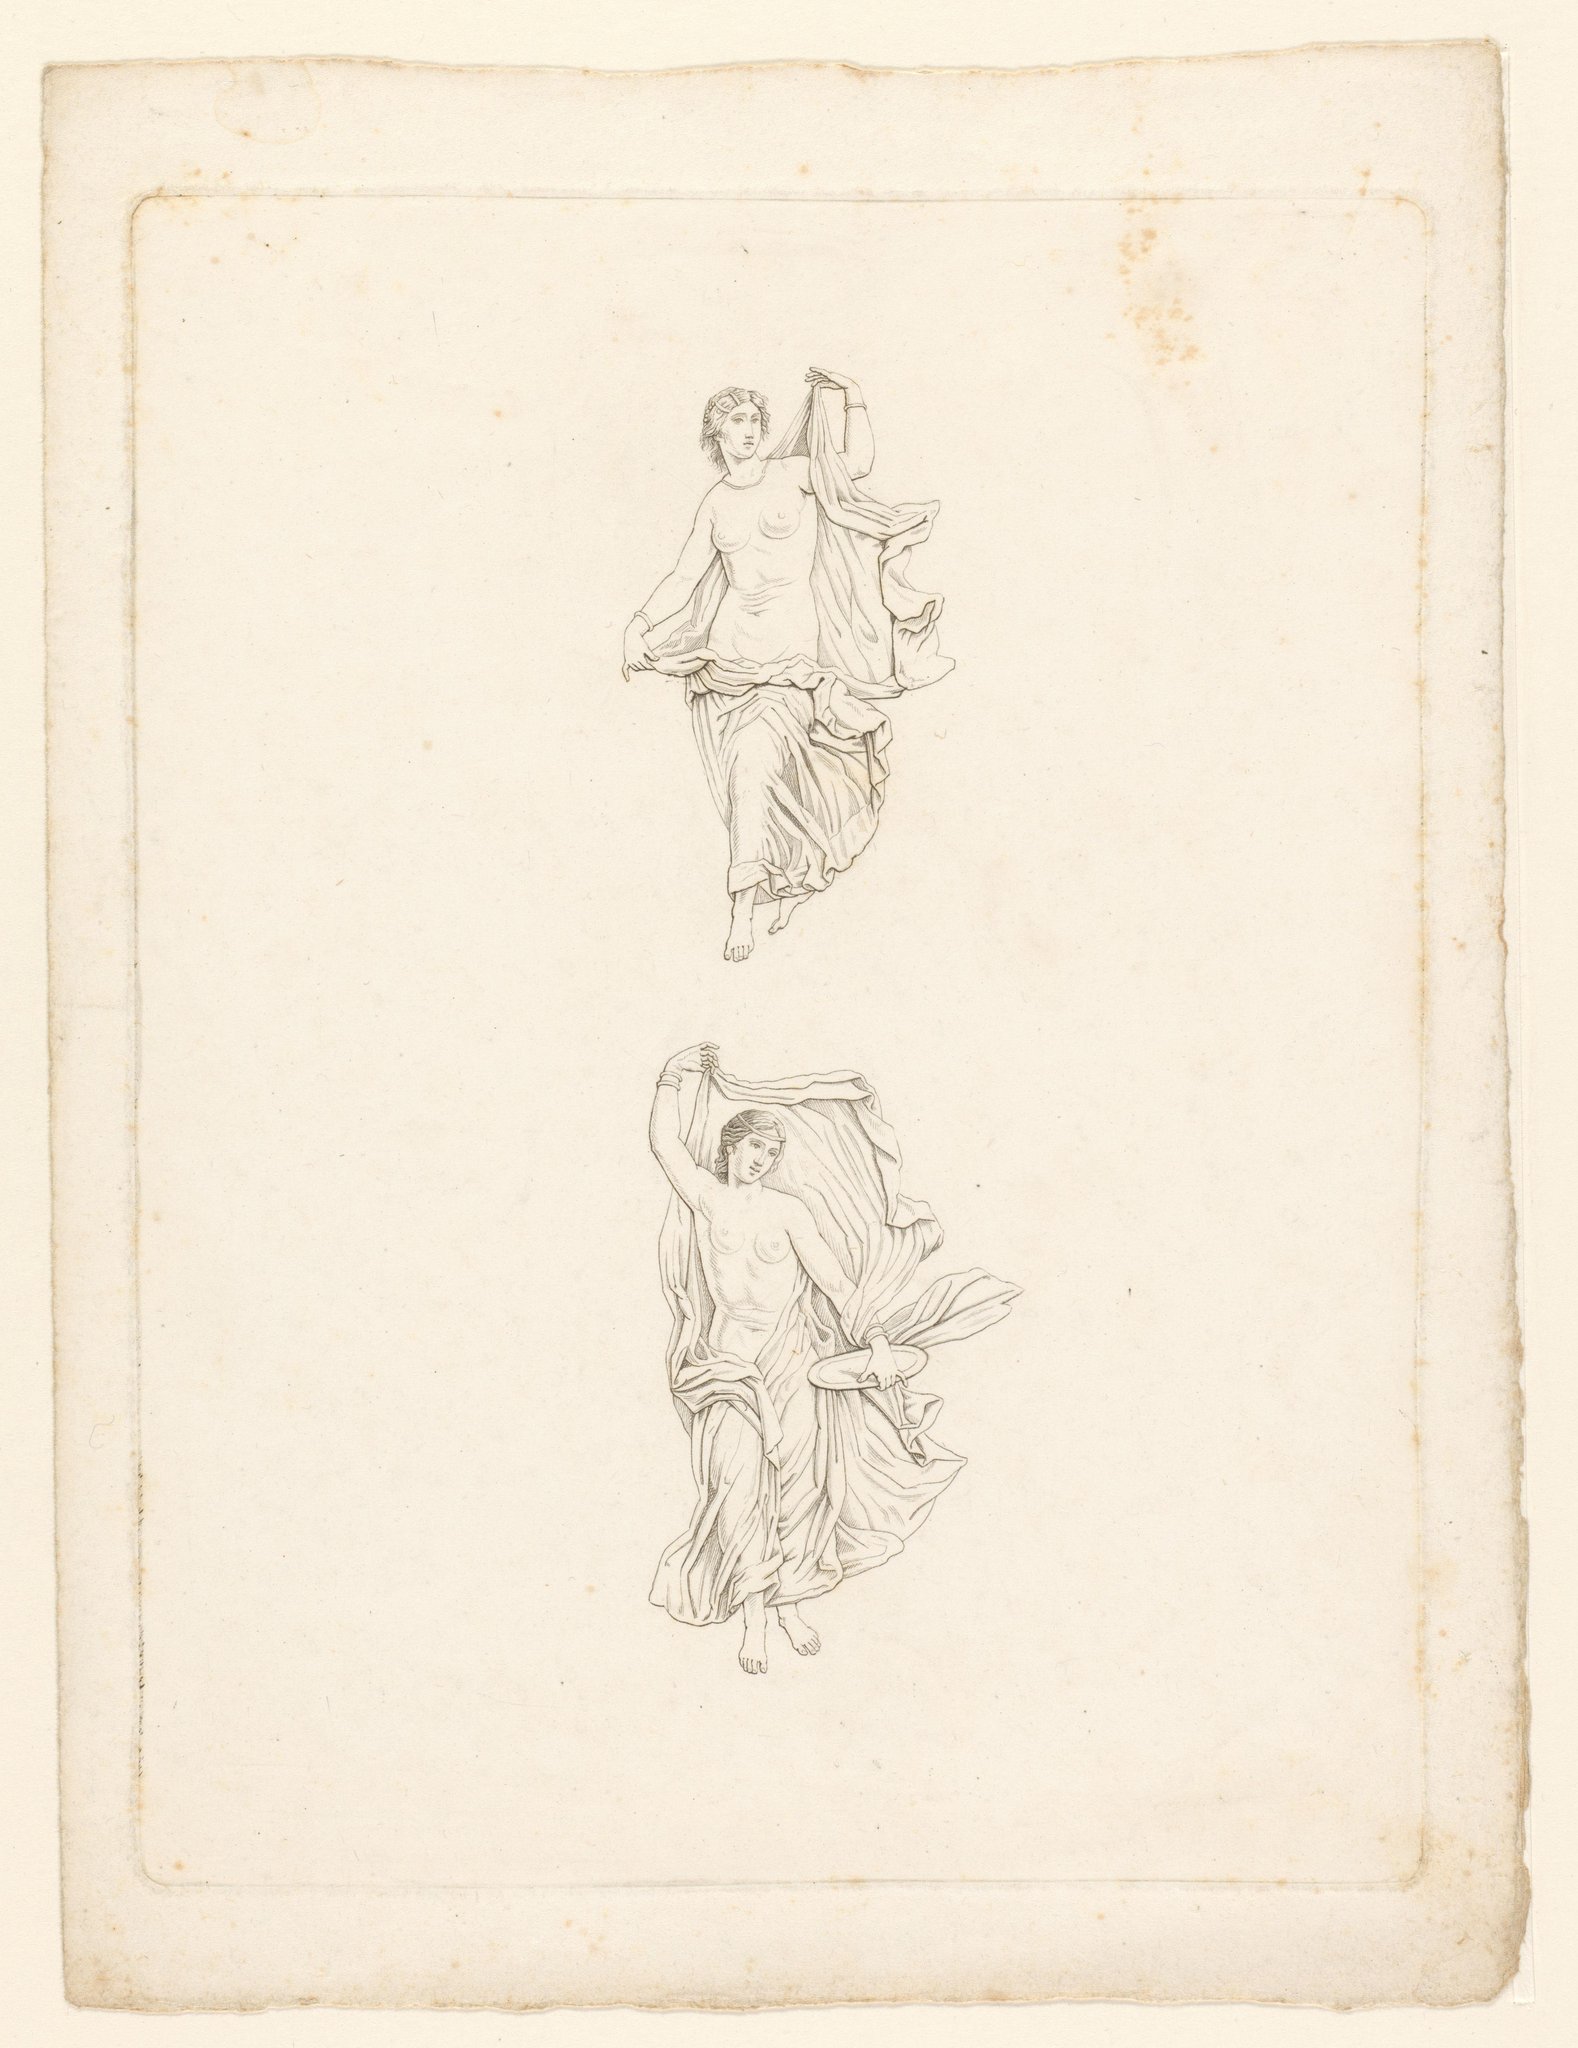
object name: print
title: Twee vrouwen met draperie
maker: Anonymous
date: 1800-1899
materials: paper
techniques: engraving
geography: italy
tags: adult woman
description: Reproductie van een fresco in Pompejaanse stijl. Twee vrouwen met draperieën, in antieke stijl.